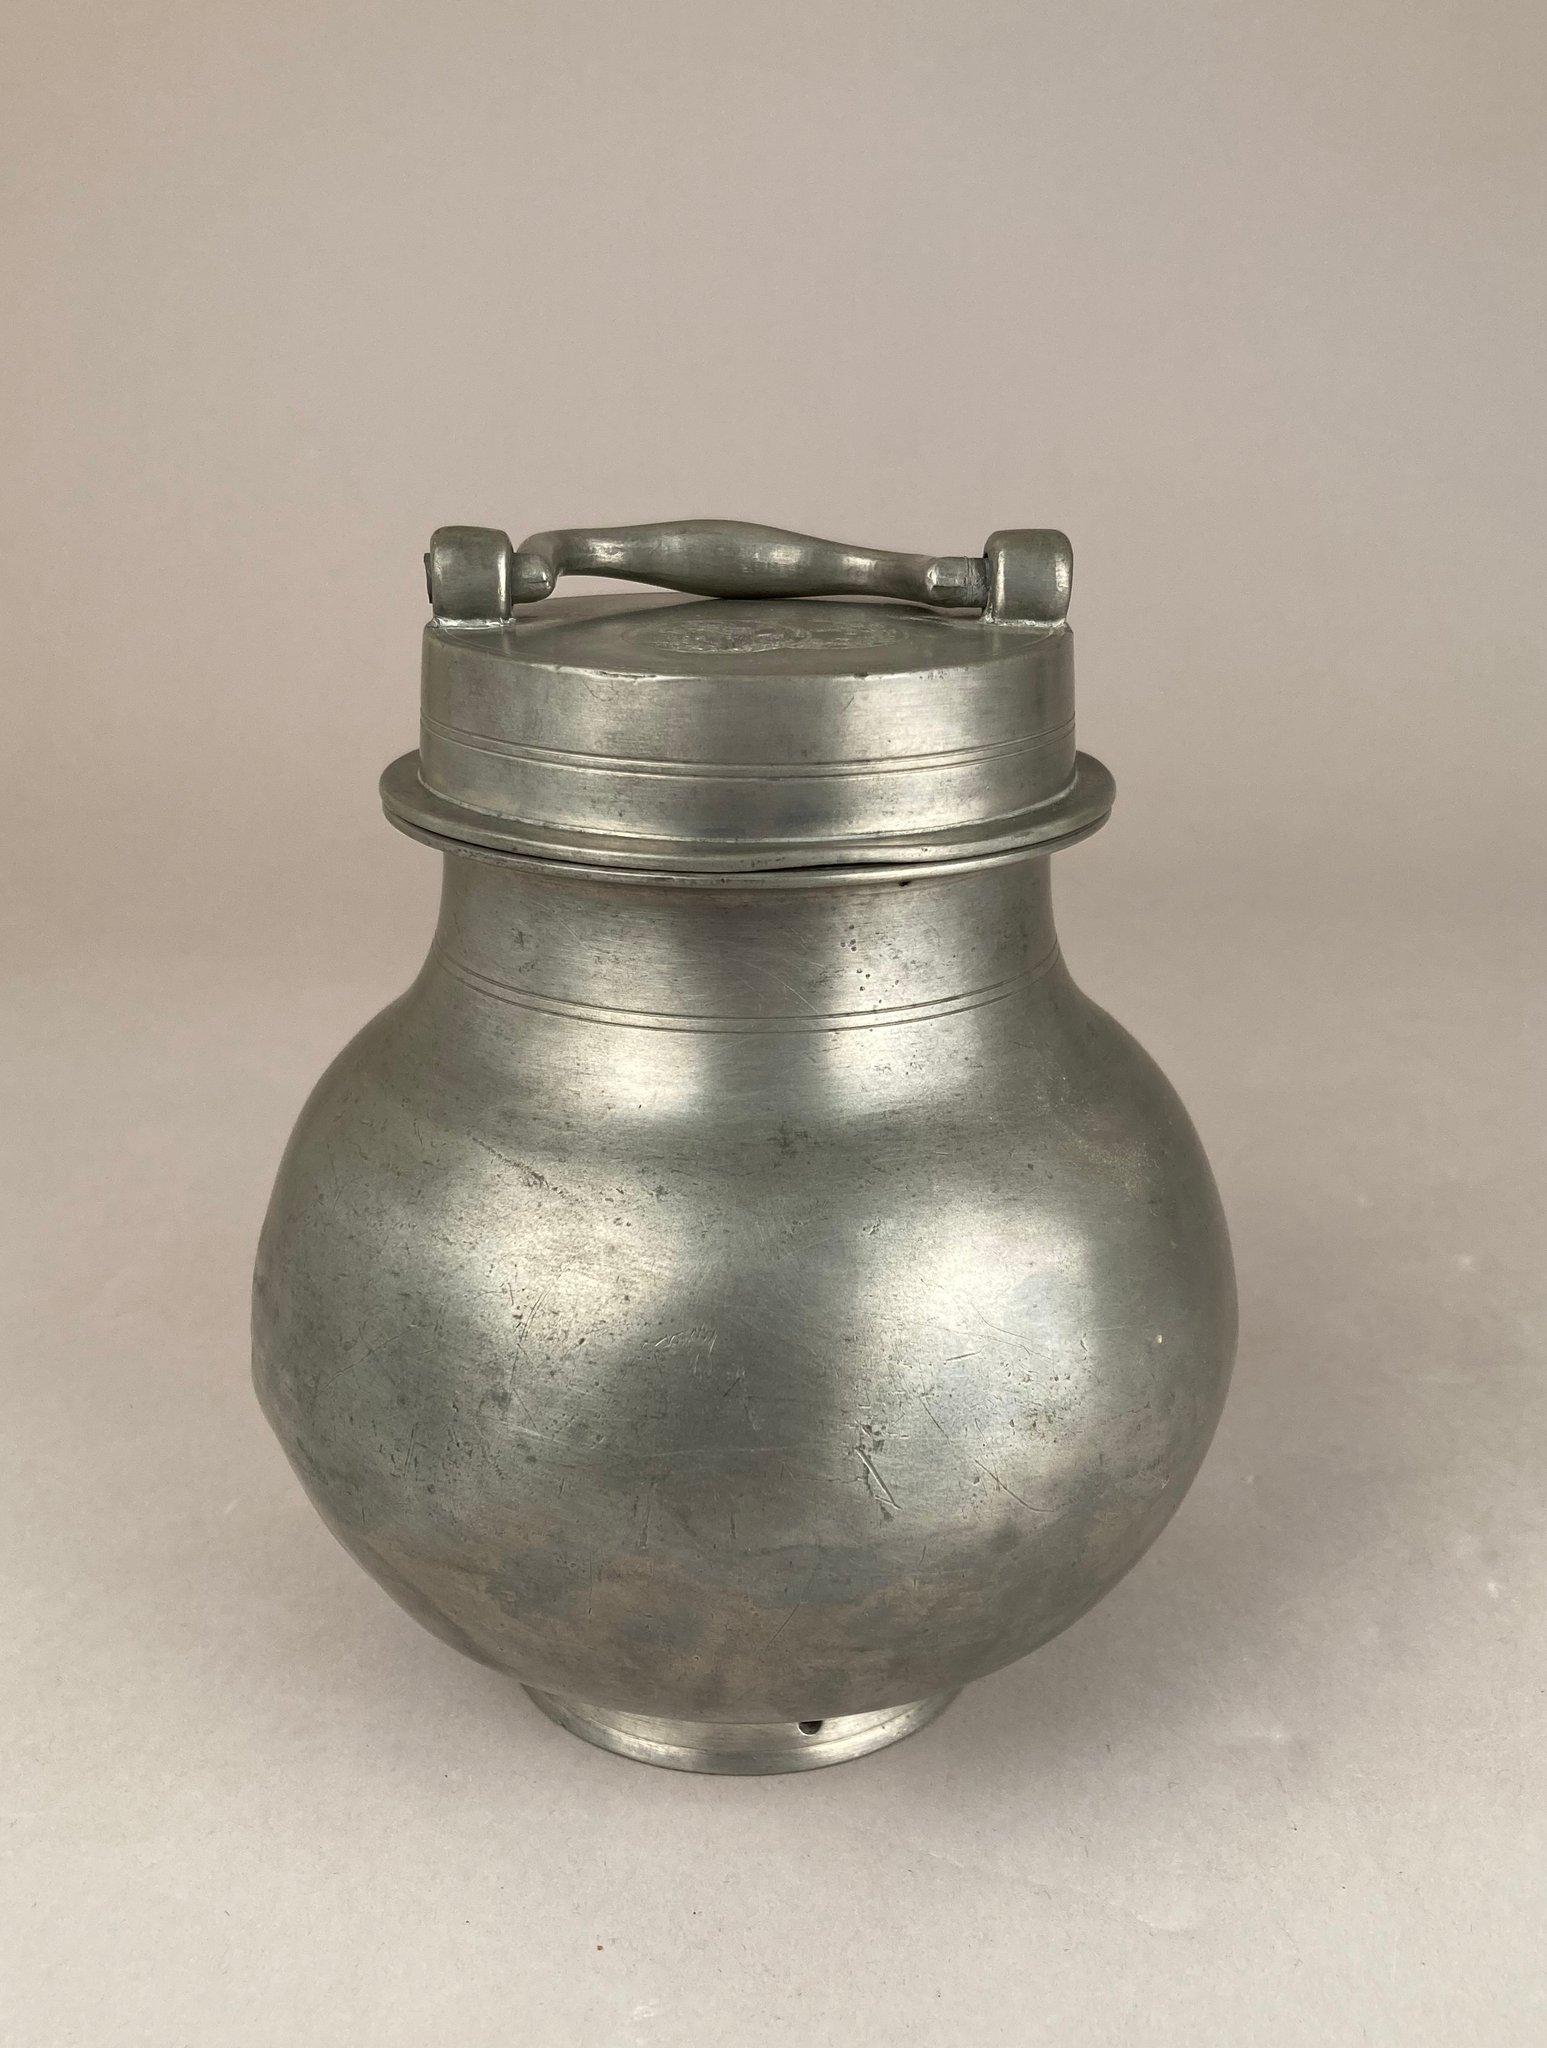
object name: jug with cover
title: Jug with insetting and outside cover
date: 1801-1900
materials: pewter